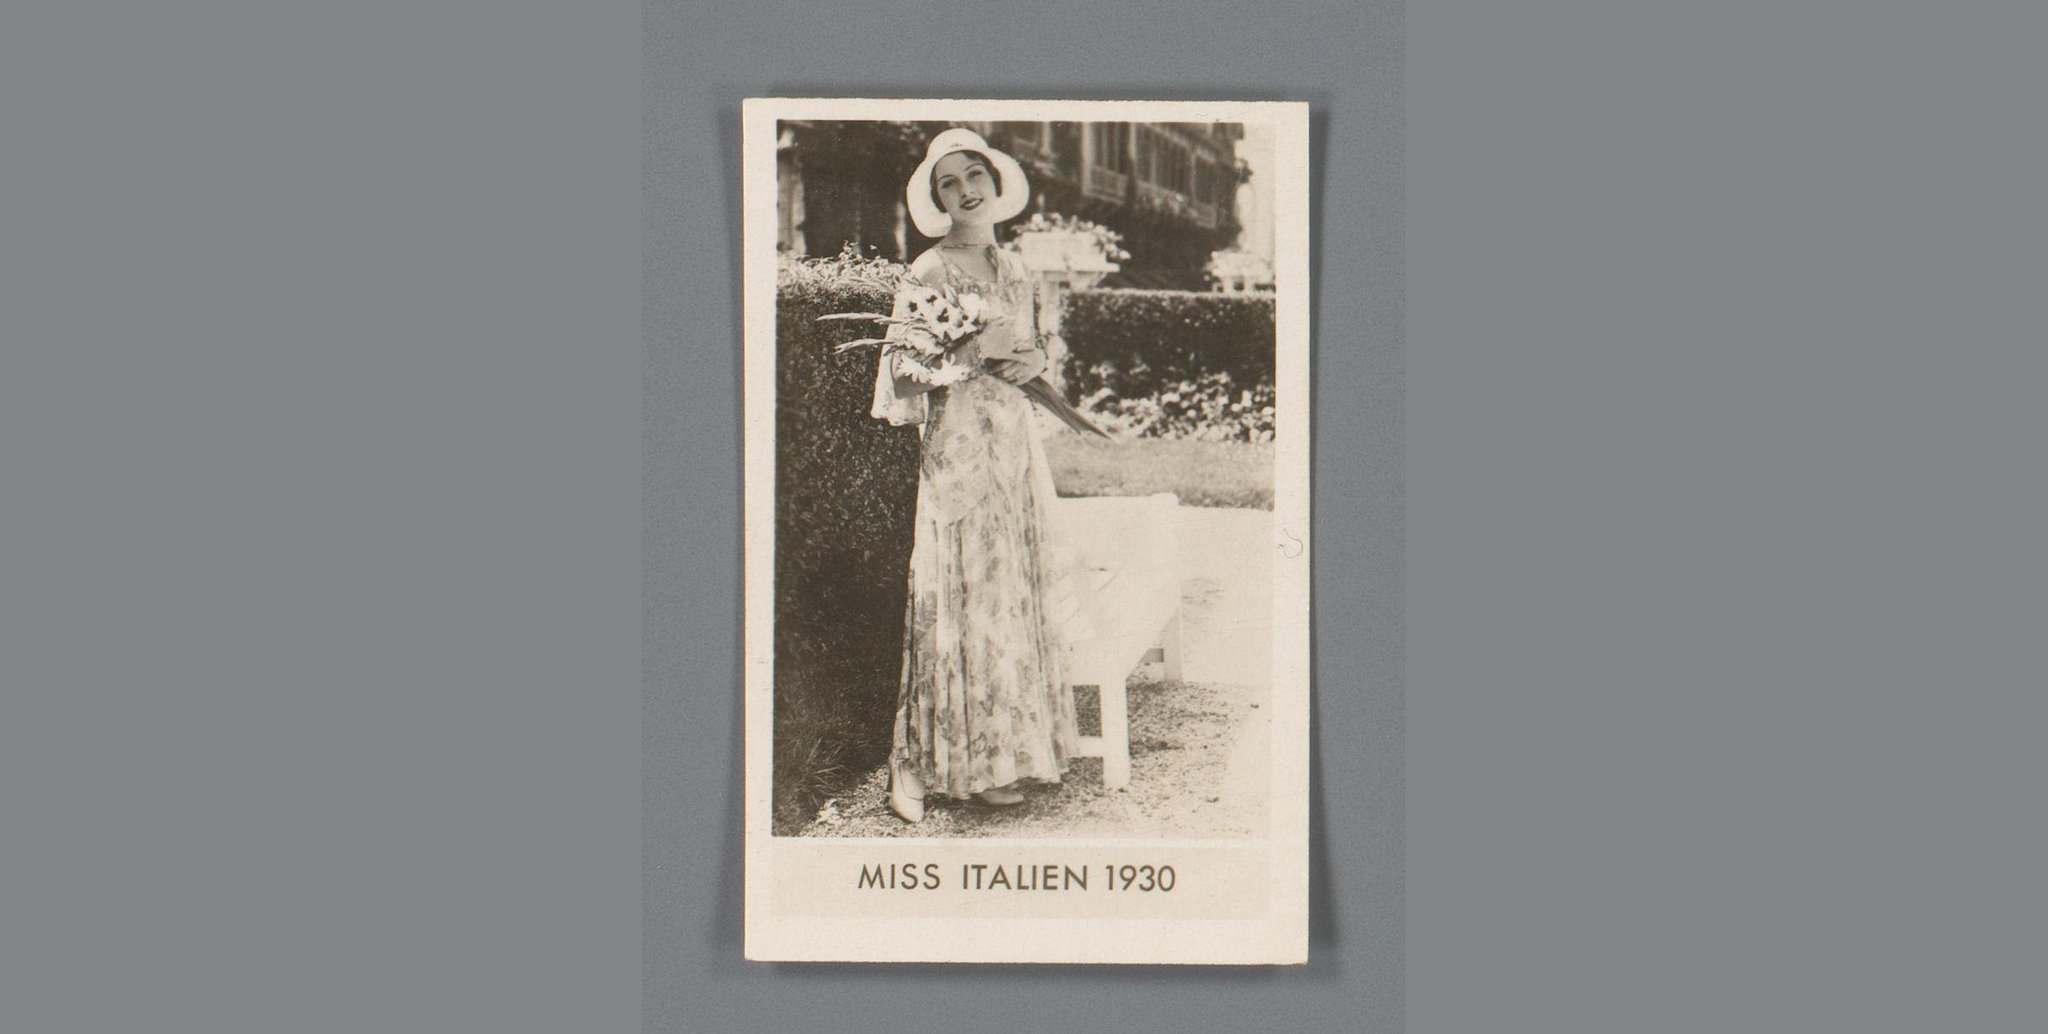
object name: photograph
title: Miss Italien 1930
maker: Anonymous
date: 1930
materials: paper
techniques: gelatin silver print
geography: dresden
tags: historical persons - bb - woman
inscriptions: inscription: ‘Die schönsten/ Frauen der Welt/ dargestellt durch die Schön-/ heitsköniginnen aller Länder,/ finden Sie in 190 echten/ Bromsilber-Fotos, die nur den/ CLUB-und-LIGA-Packun-/ gen beiliegen. Eind prächtiges/ Sammel-Album erhalten Sie/ für 75 Pfennig vom Händler/ oder bei Einsendung von/ 75 Pfennig in Briefmarken/ von der Bilderstelle Lohse,/ Dresden A24, Nossener Str. 1./ Ges. gesch. Nachdruck verboten!’